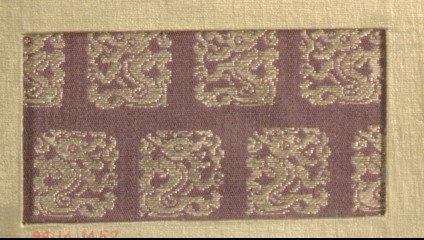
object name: piece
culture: japanese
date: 1801-1900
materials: metal thread, silk